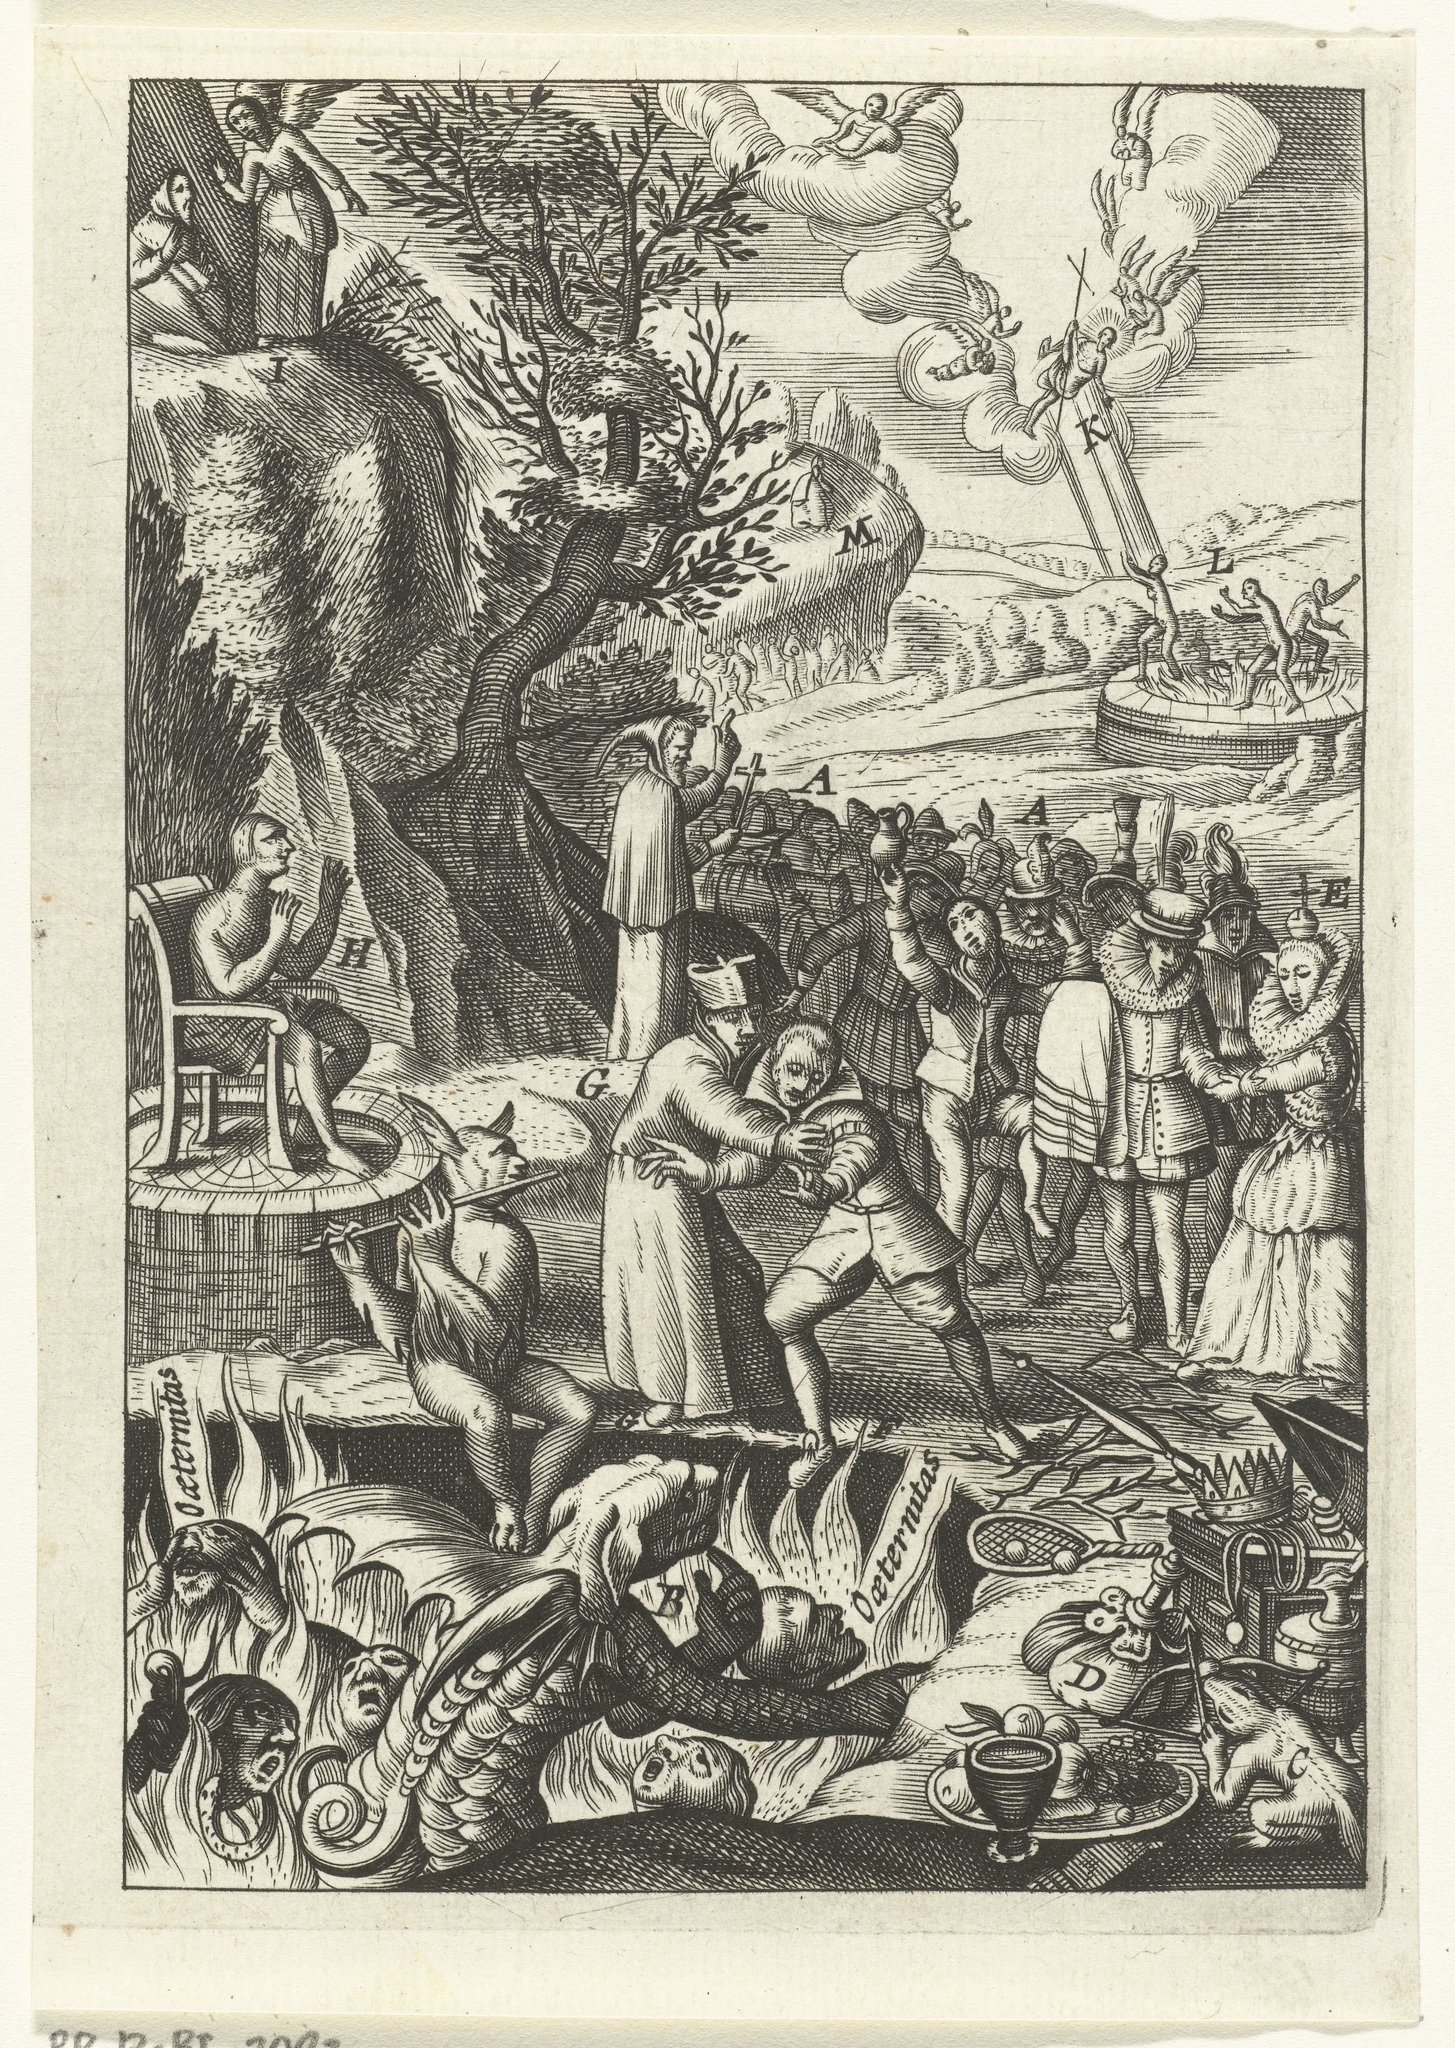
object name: book illustration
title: Embleem met bisschop die een man beschermt tegen de verzoekingen van een duivel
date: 1620-1649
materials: paper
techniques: engraving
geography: antwerp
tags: the life of man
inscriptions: collector's mark: Lugt 2228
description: Een man staat op het randje van de afgrond bij het vagevuur en wordt door de duivel gelokt met rijkdom en overvloed. Een bisschop houdt hem echter tegen. Achter de man volgt een stoet losbandige mannen en vrouwen die gedoemd zijn tot het vagevuur.